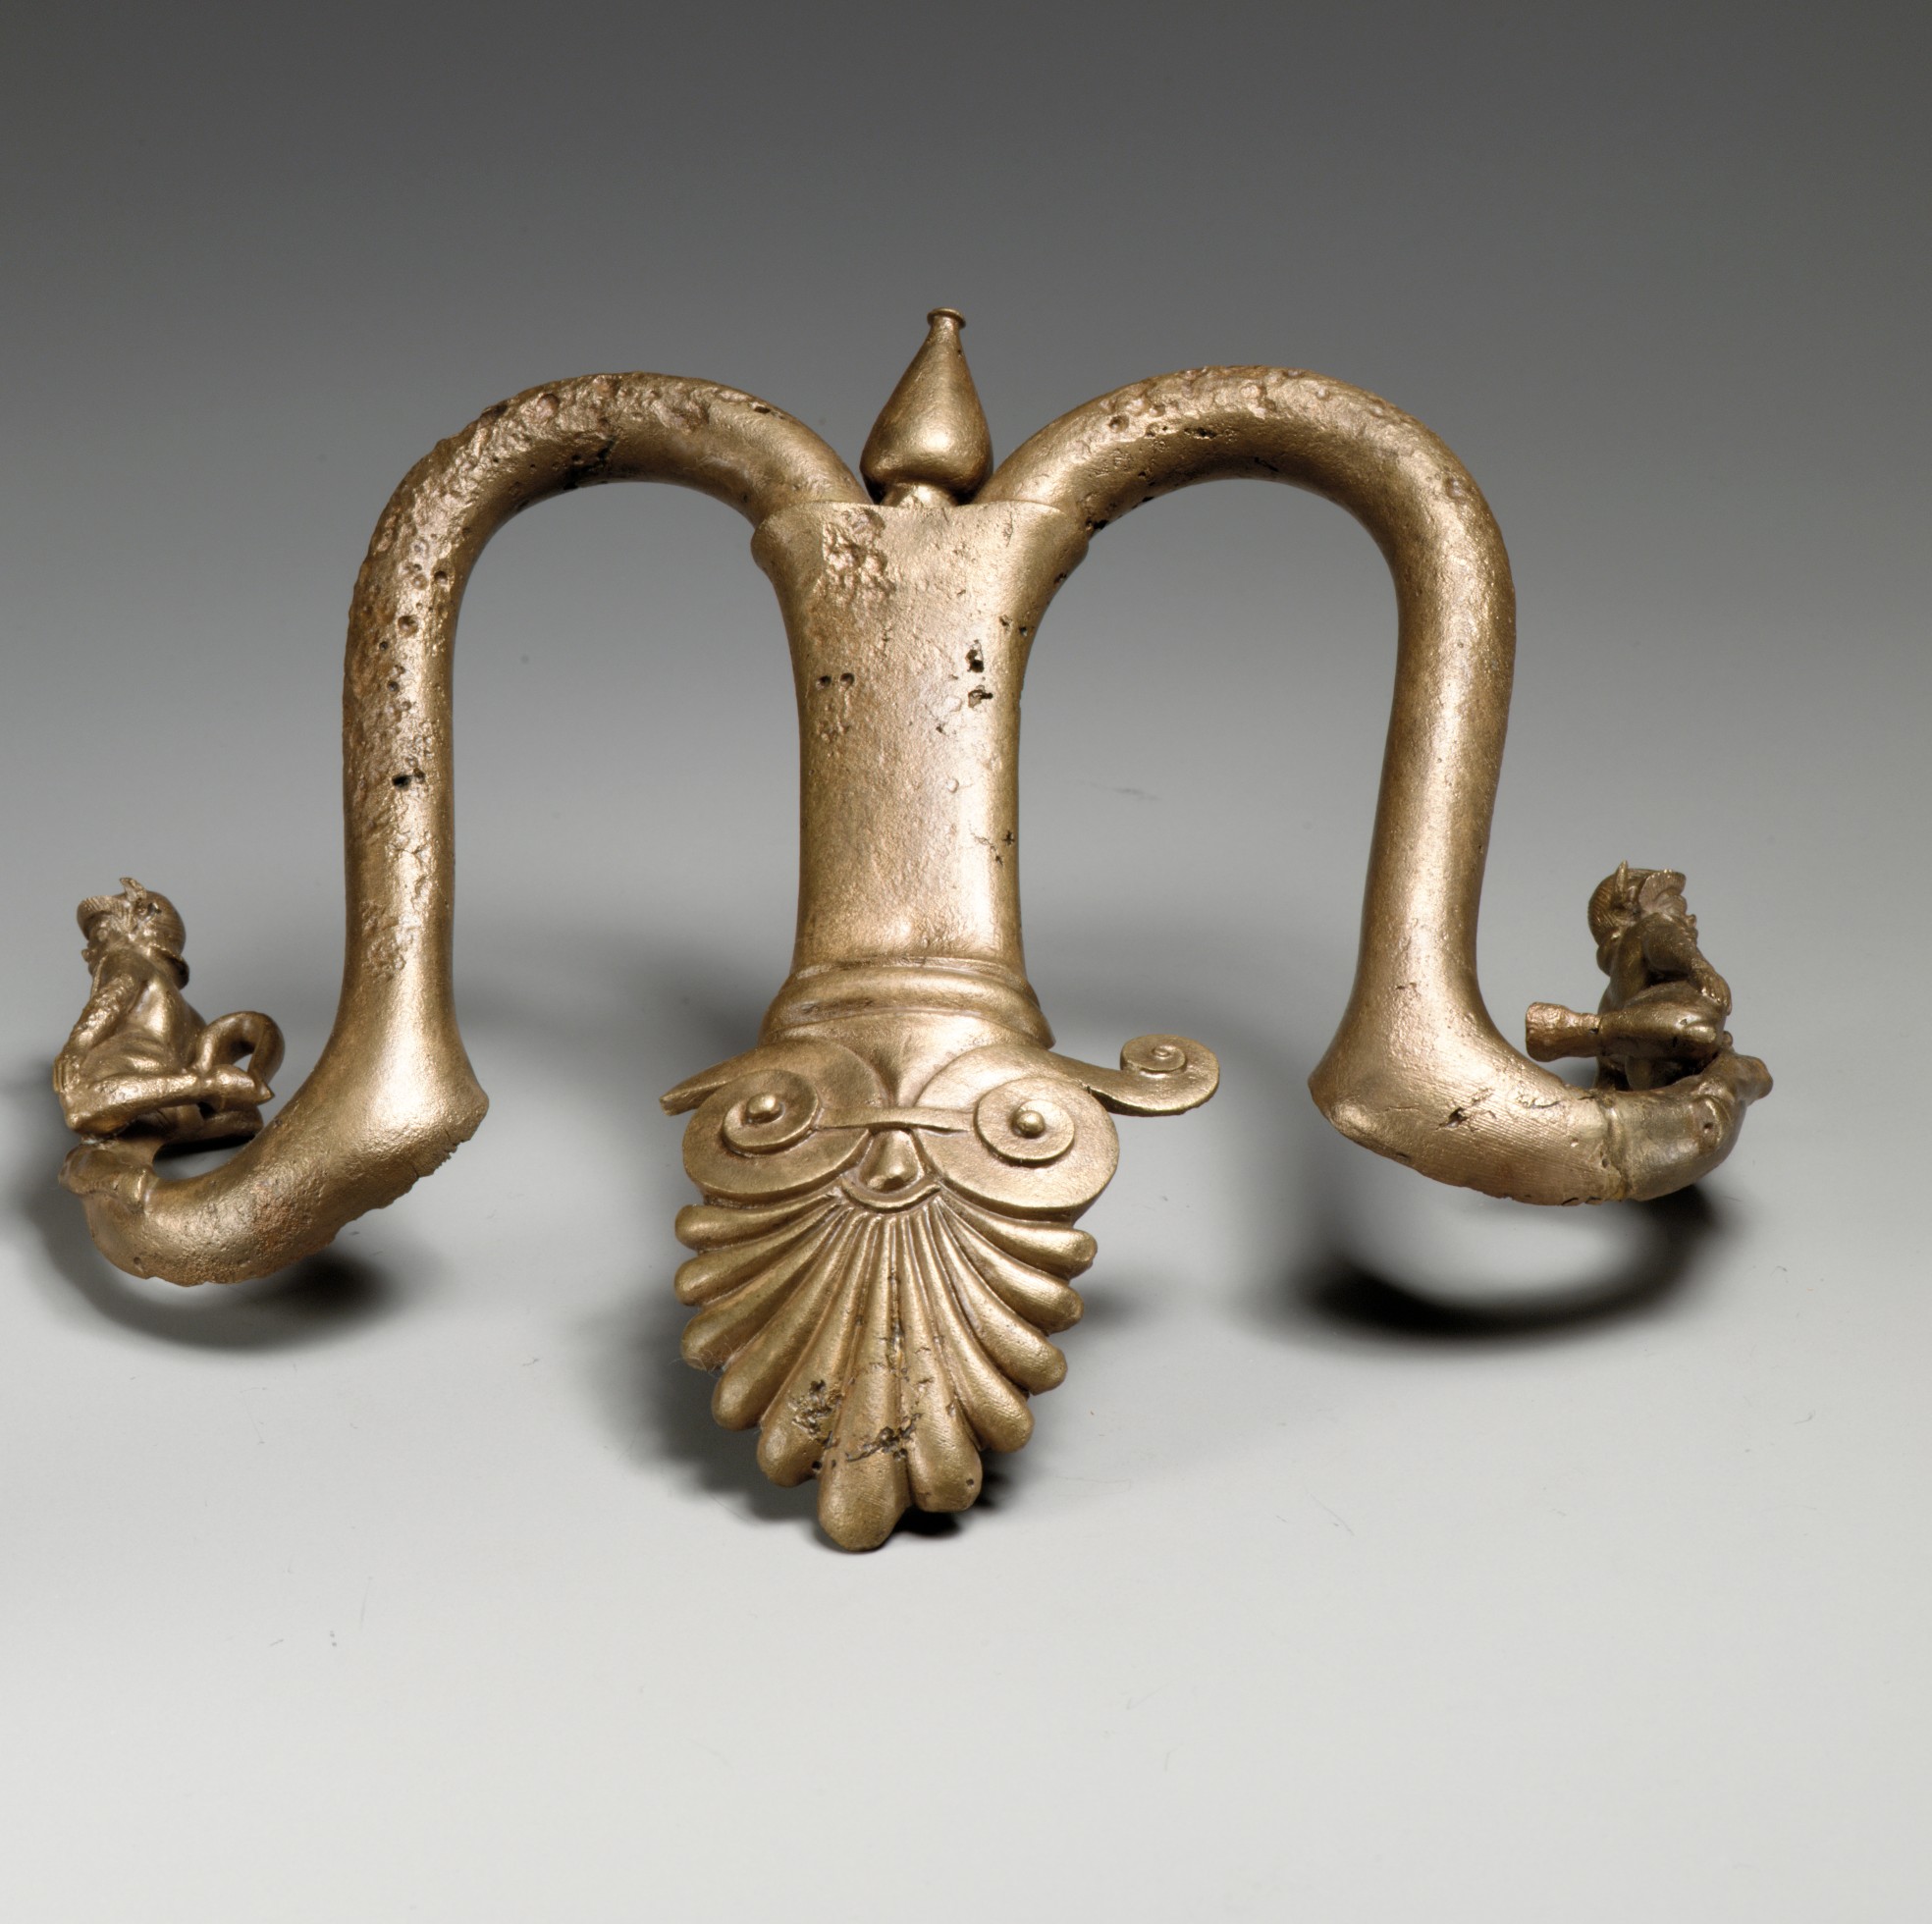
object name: handle and foot of a louterion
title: Handles and feet of a bronze louterion (basin)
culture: greek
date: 500-476 BCE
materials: bronze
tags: palmettes,satyrs